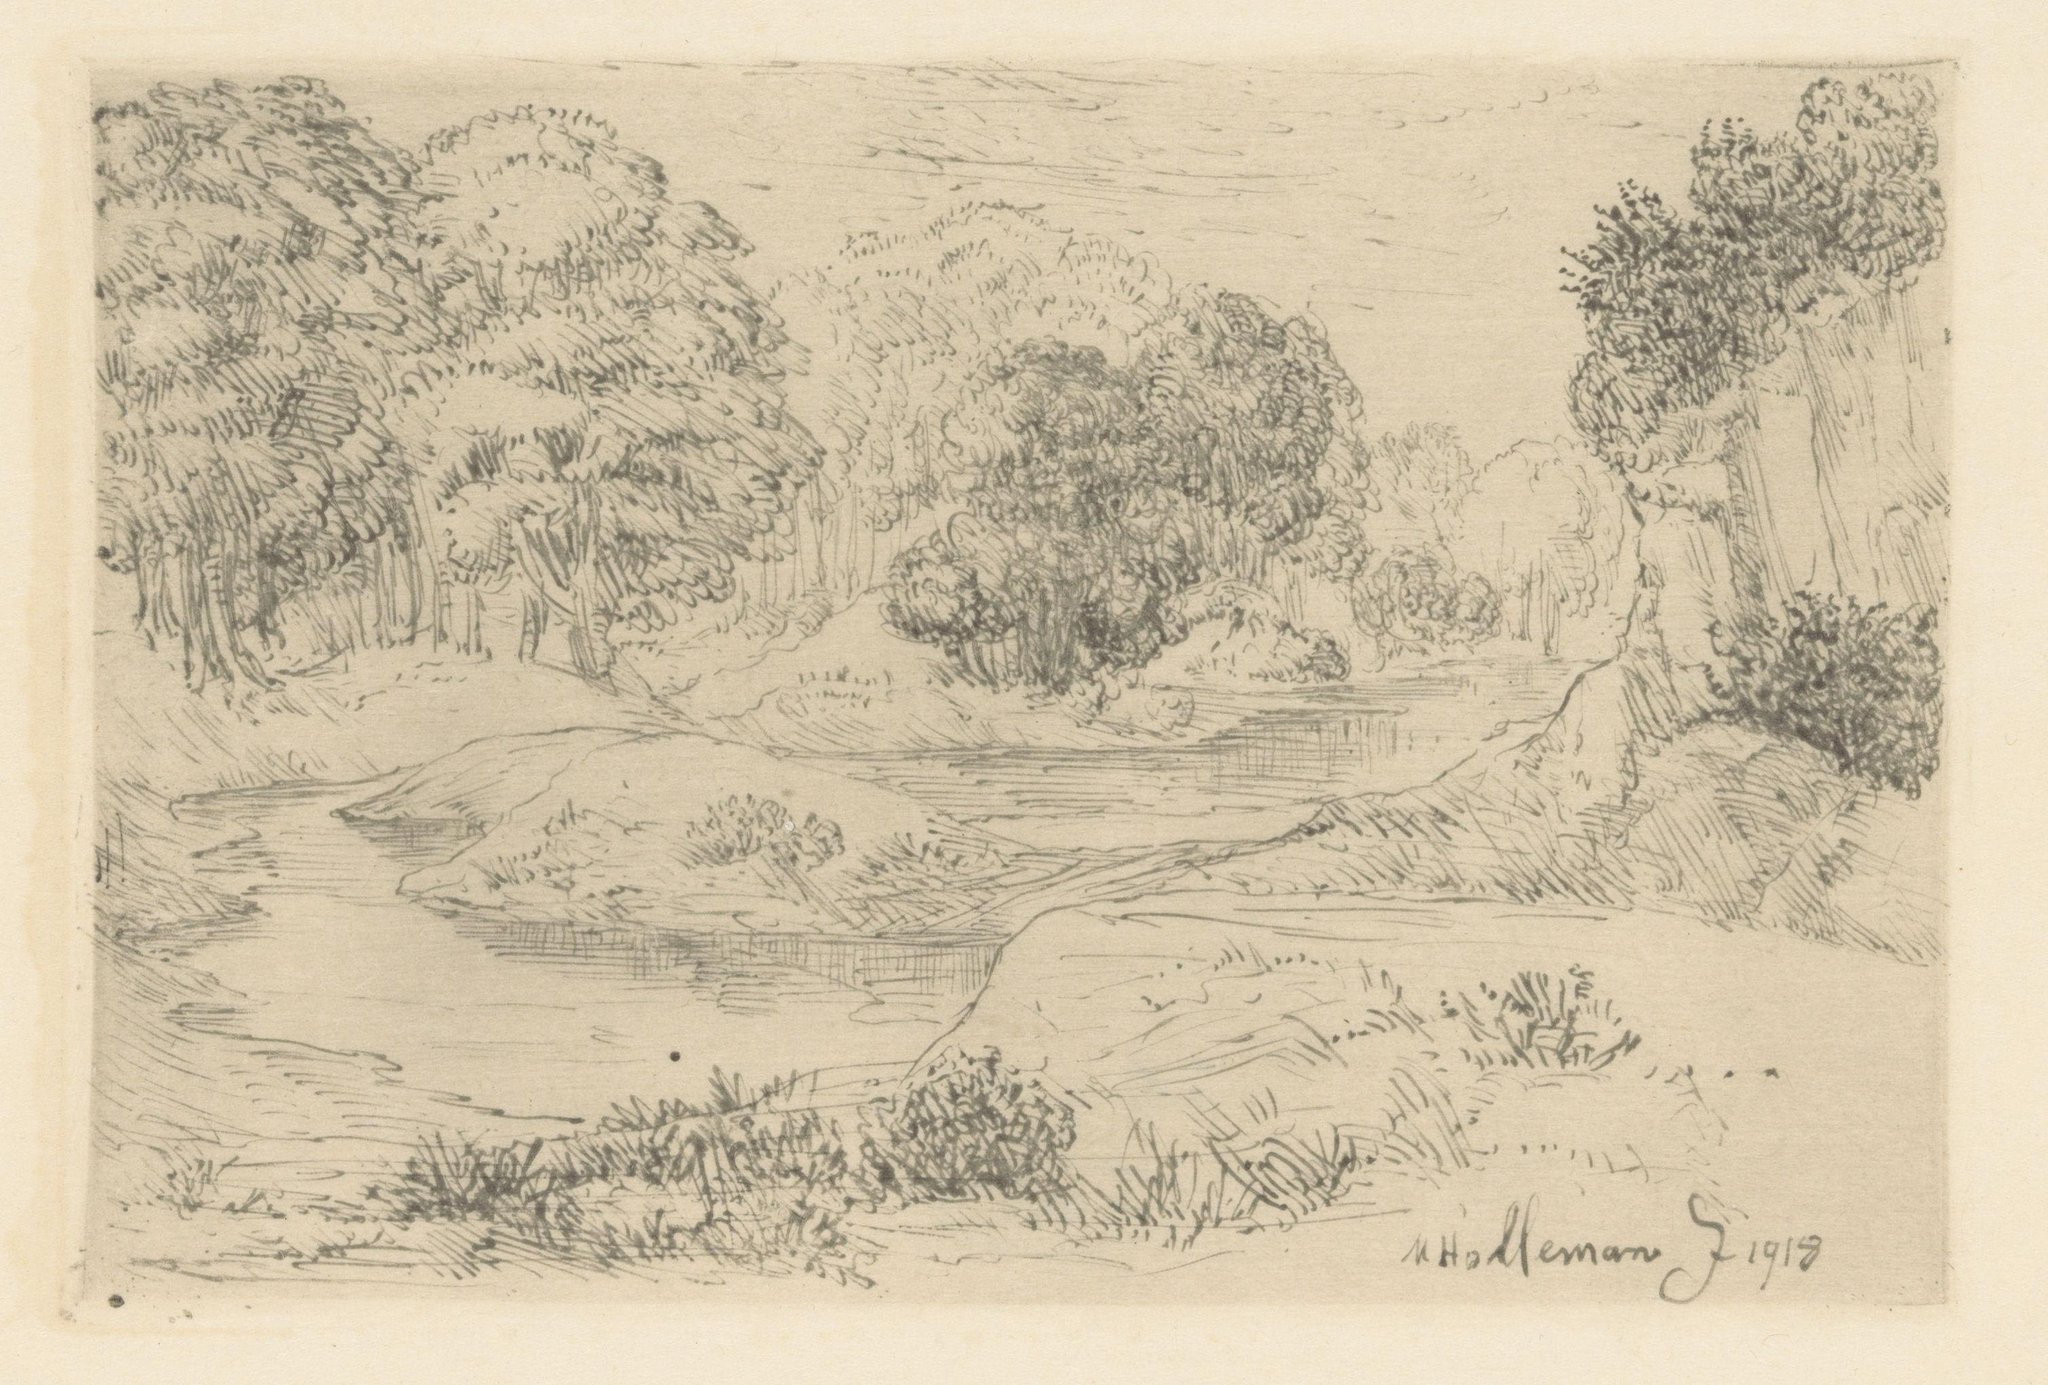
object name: print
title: Park met vijver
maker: marius holleman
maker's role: draughtsman, print maker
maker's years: 1878-1926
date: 1918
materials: paper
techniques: etching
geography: groningen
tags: pond, pool, public gardens, park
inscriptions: collector's mark: Lugt 2228